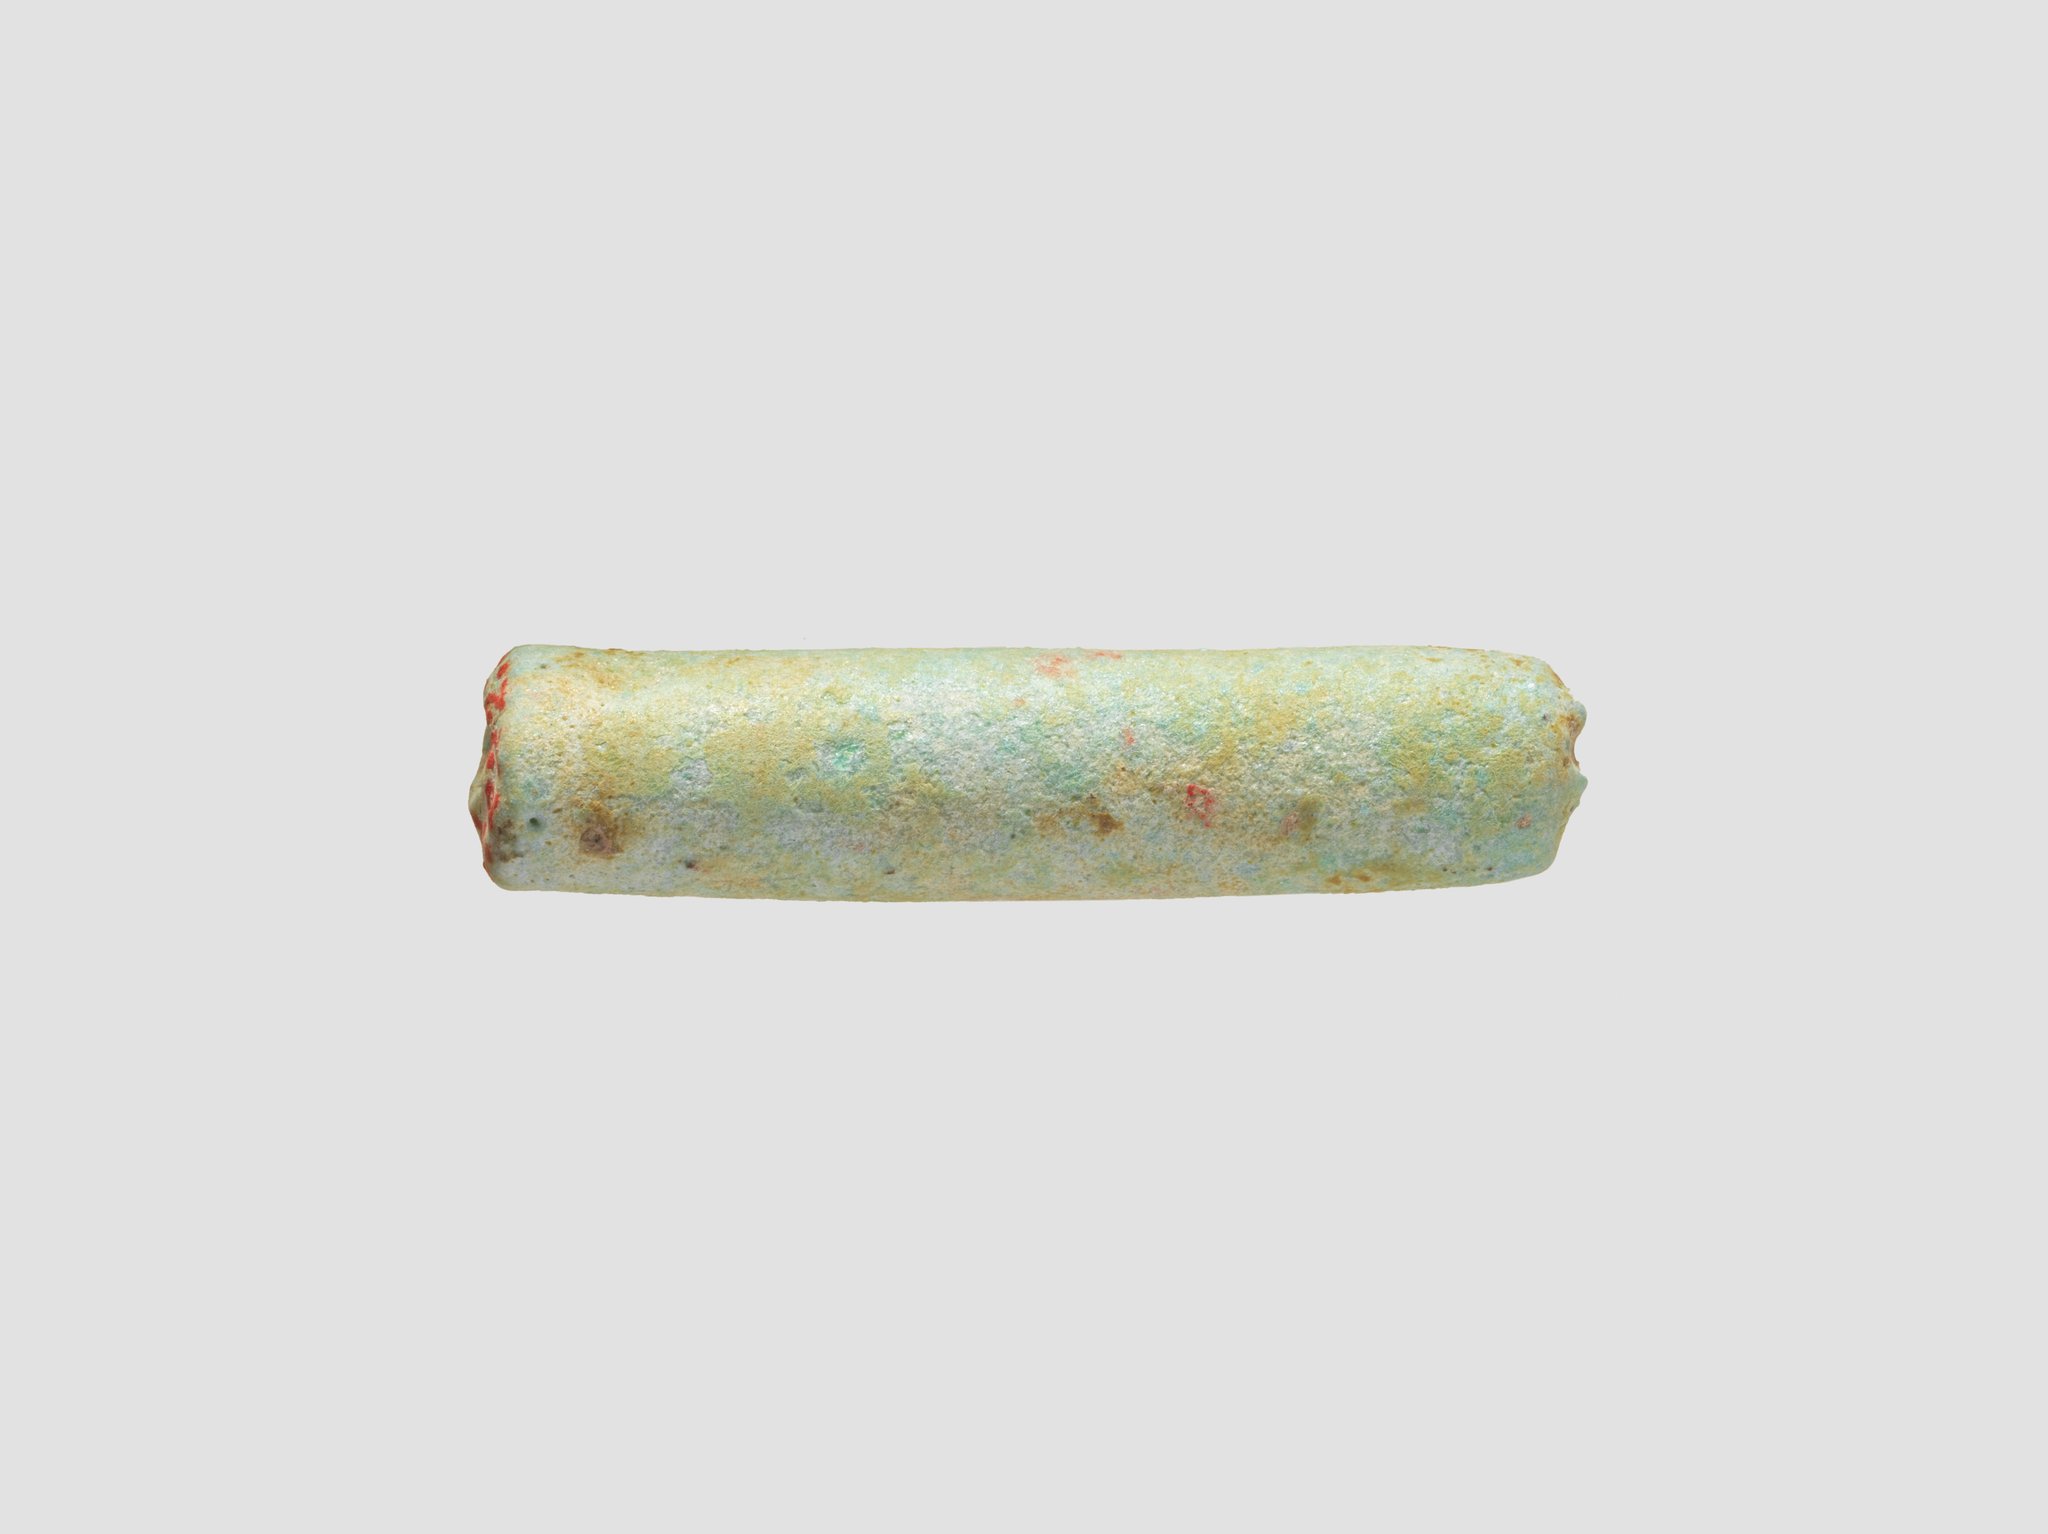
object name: ornament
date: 2333-2001 BCE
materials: faience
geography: mesopotamia